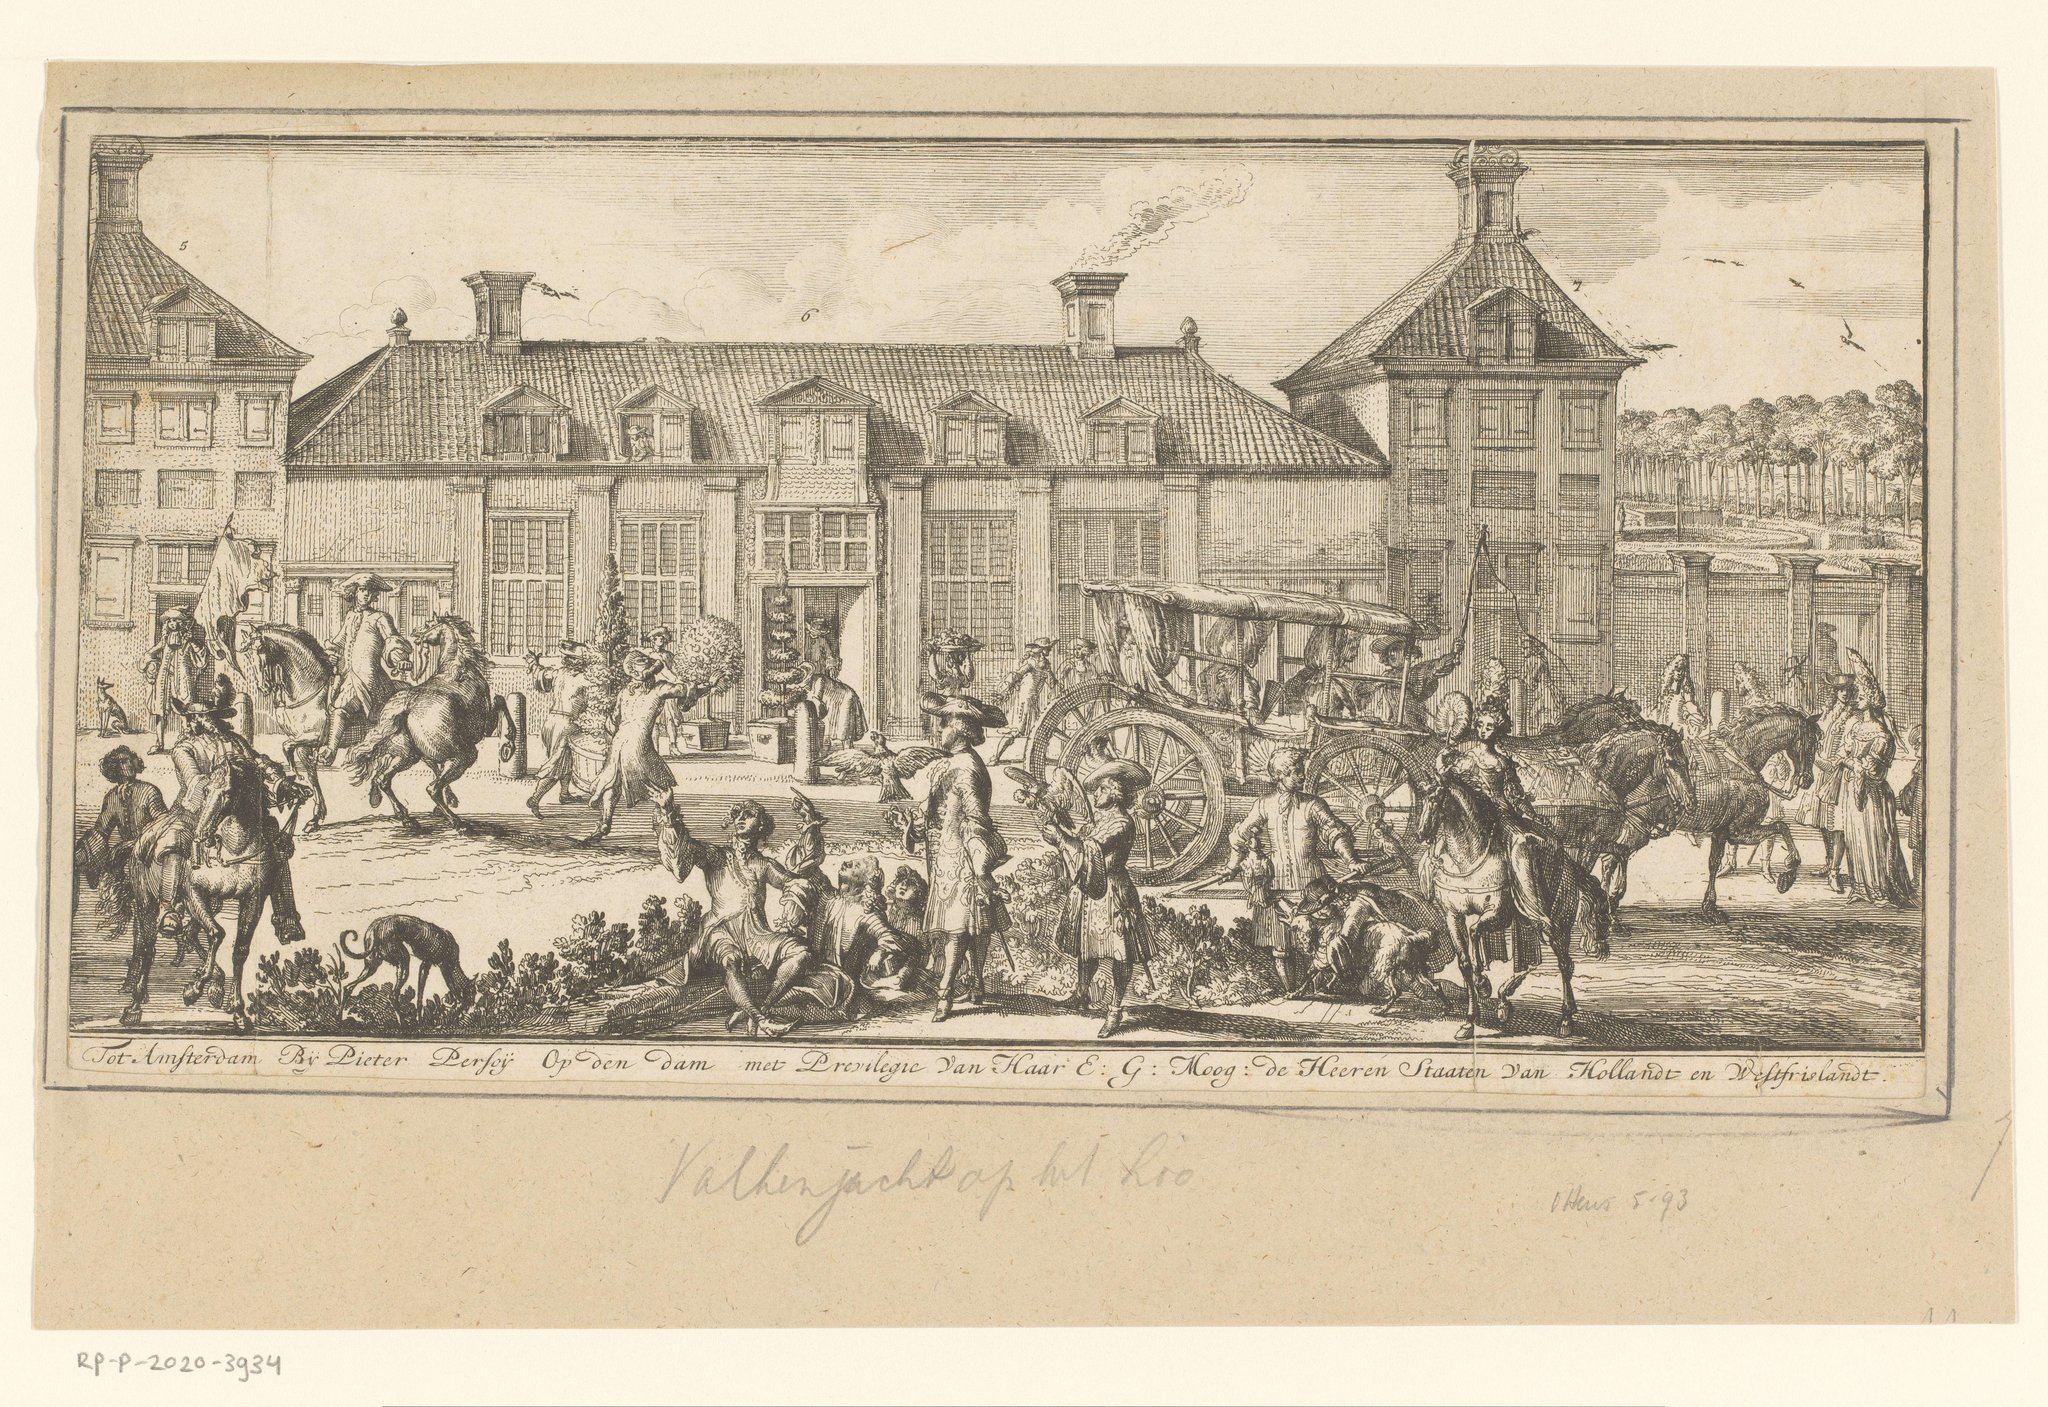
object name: print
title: Gezichten op Paleis Het Loo, de bijbehorende gebouwen en het bijbehorende park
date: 1690-1694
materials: paper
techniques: etching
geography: haarlem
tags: the hague, william iii (prince of orange and king of england, scotland, and ireland), sports, games ~ animals (+ hunting with falcon, hawk; falconry), four-wheeled, animal-drawn vehicle, e.g.: cab, carriage, coach, palace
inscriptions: collector's mark: Lugt 2228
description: Gezicht op het rechterdeel van Paleis Het Loo, met valkeniers, ruiters, een koets en voornaam geklede mannen en vrouwen ervoor.